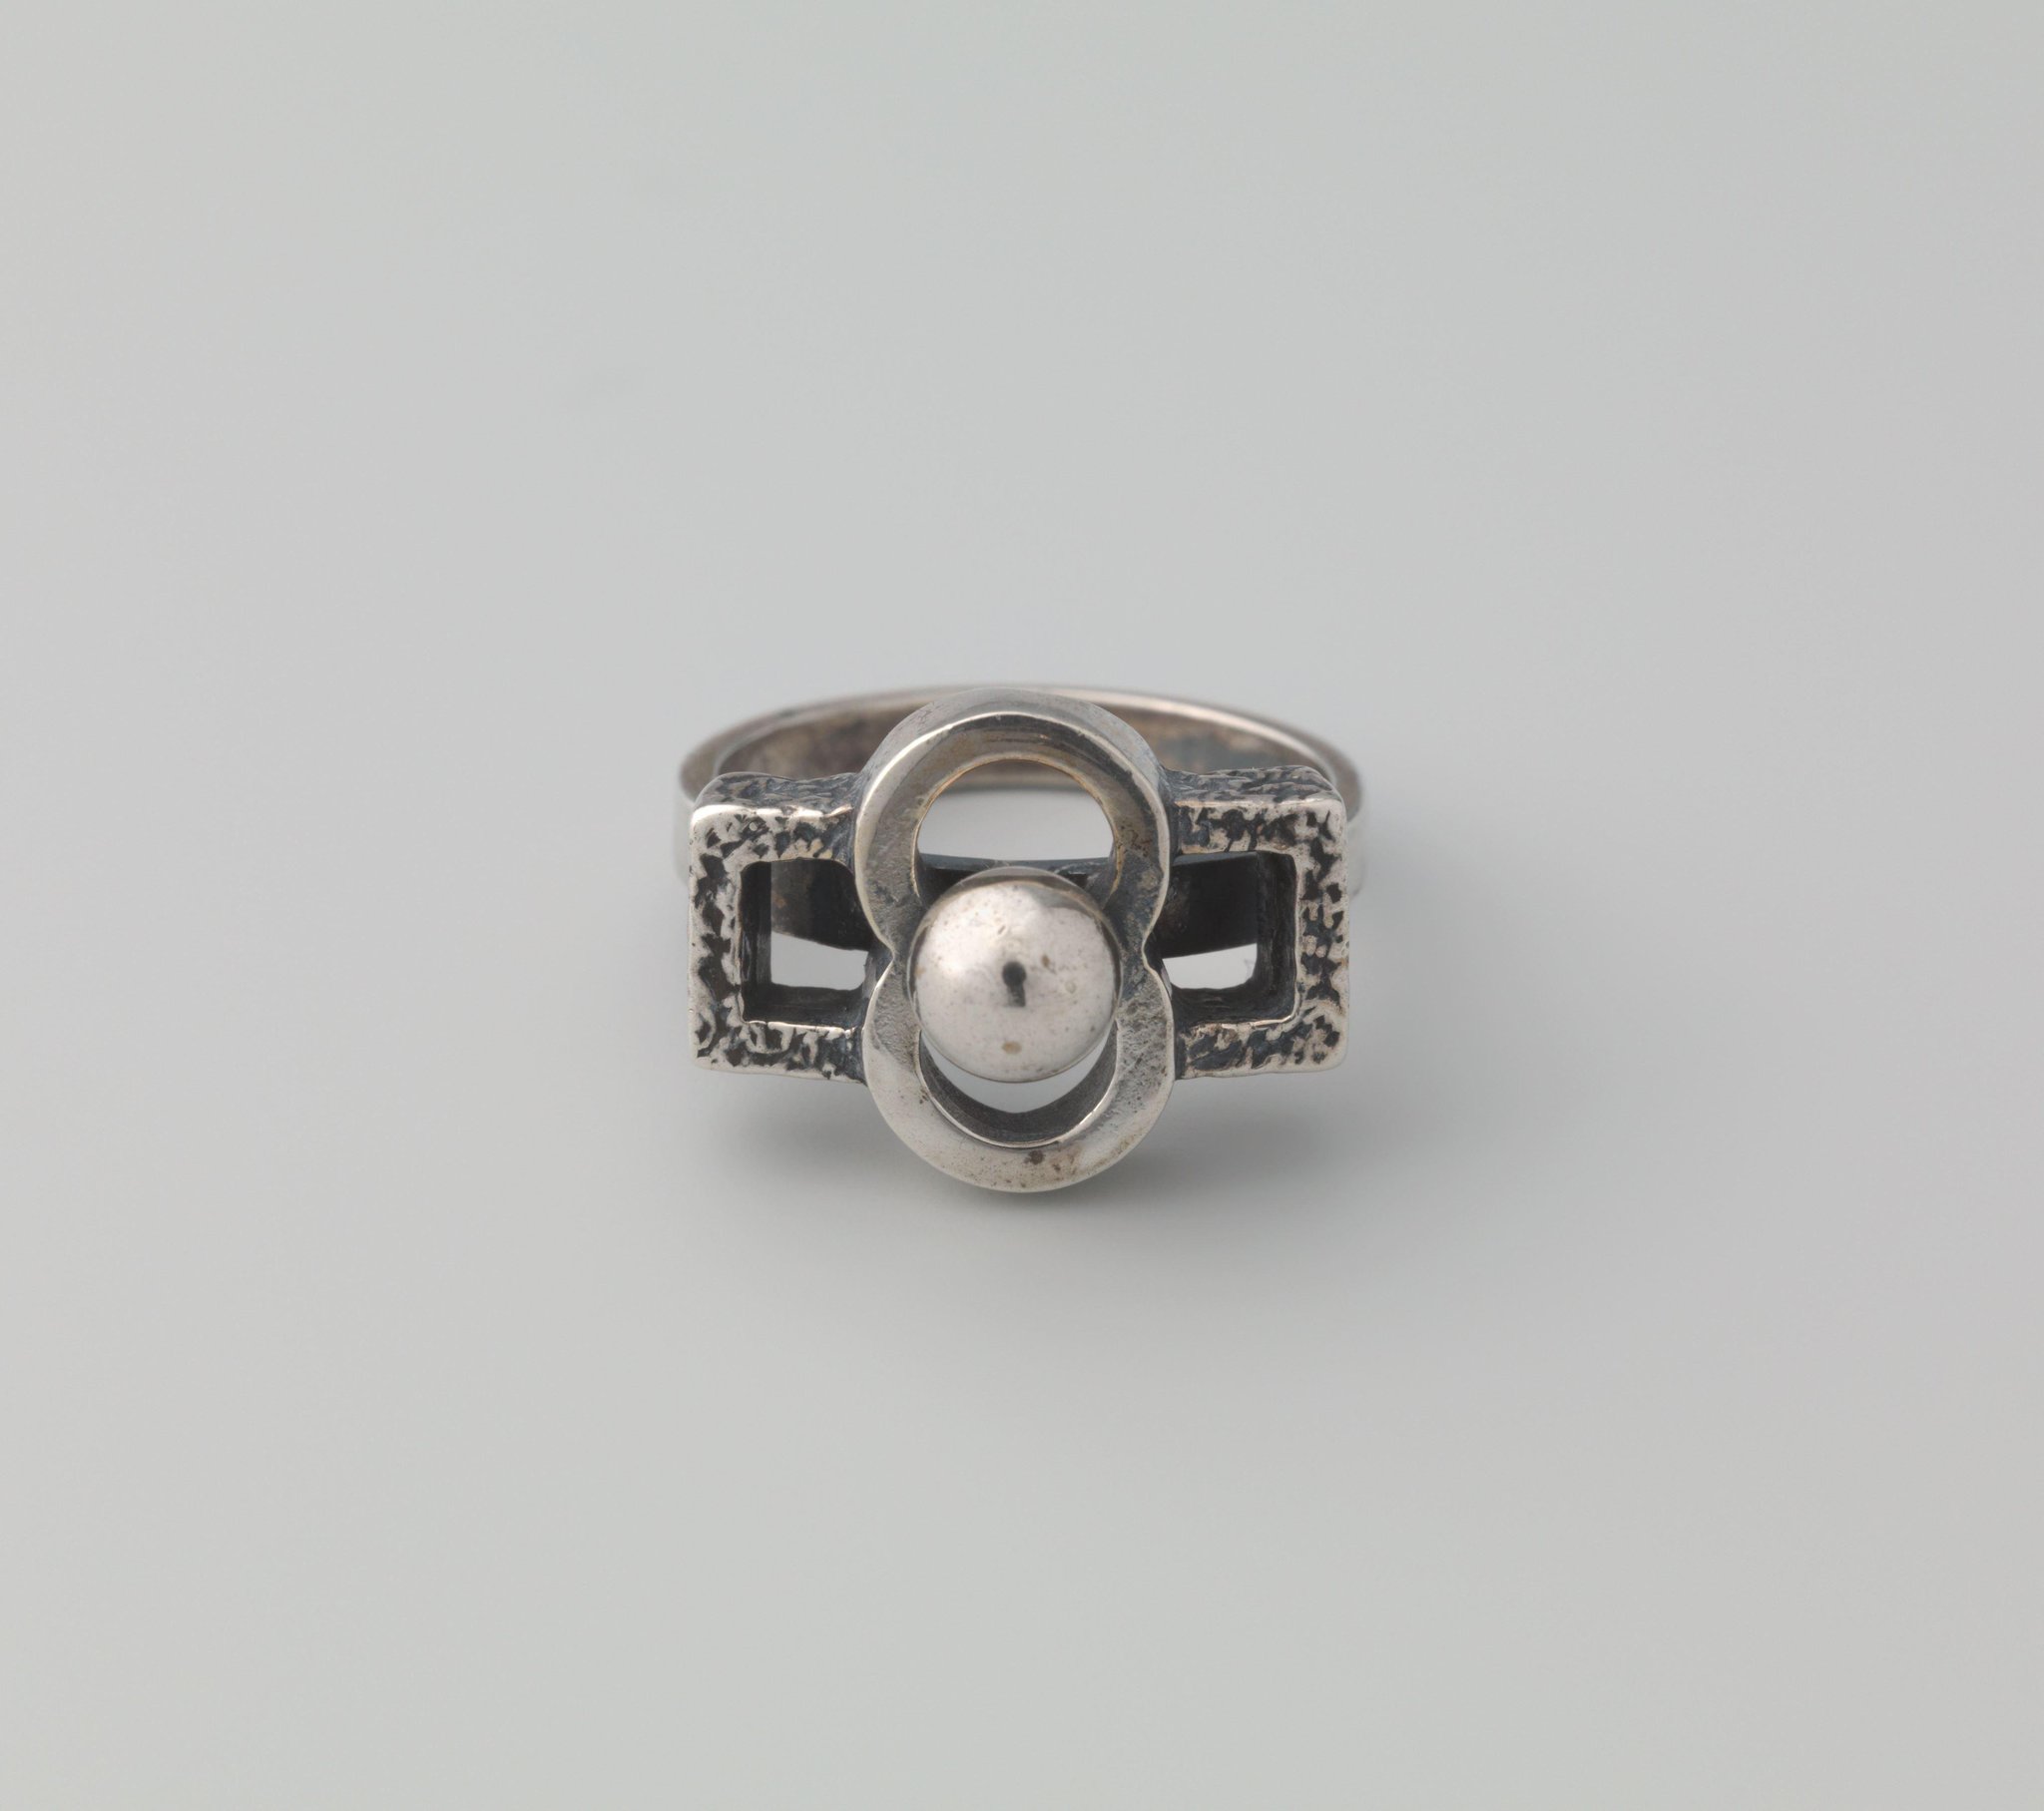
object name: ring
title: Tienerring met geometrische knop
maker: Anonymous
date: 1960-1970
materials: silver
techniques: blackening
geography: netherlands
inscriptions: maker's mark: ‘Nxx’, alloy mark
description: Tienerring van zilver met geometrische knop. De knop bestaat uit een rechthoek met een ruwe gezwarte textuur die in het midden wordt doorsneden door twee elkaar overlappende gladde cirkels. Daar waar de cirkels elkaar snijden is een gladde bol geplaatst.